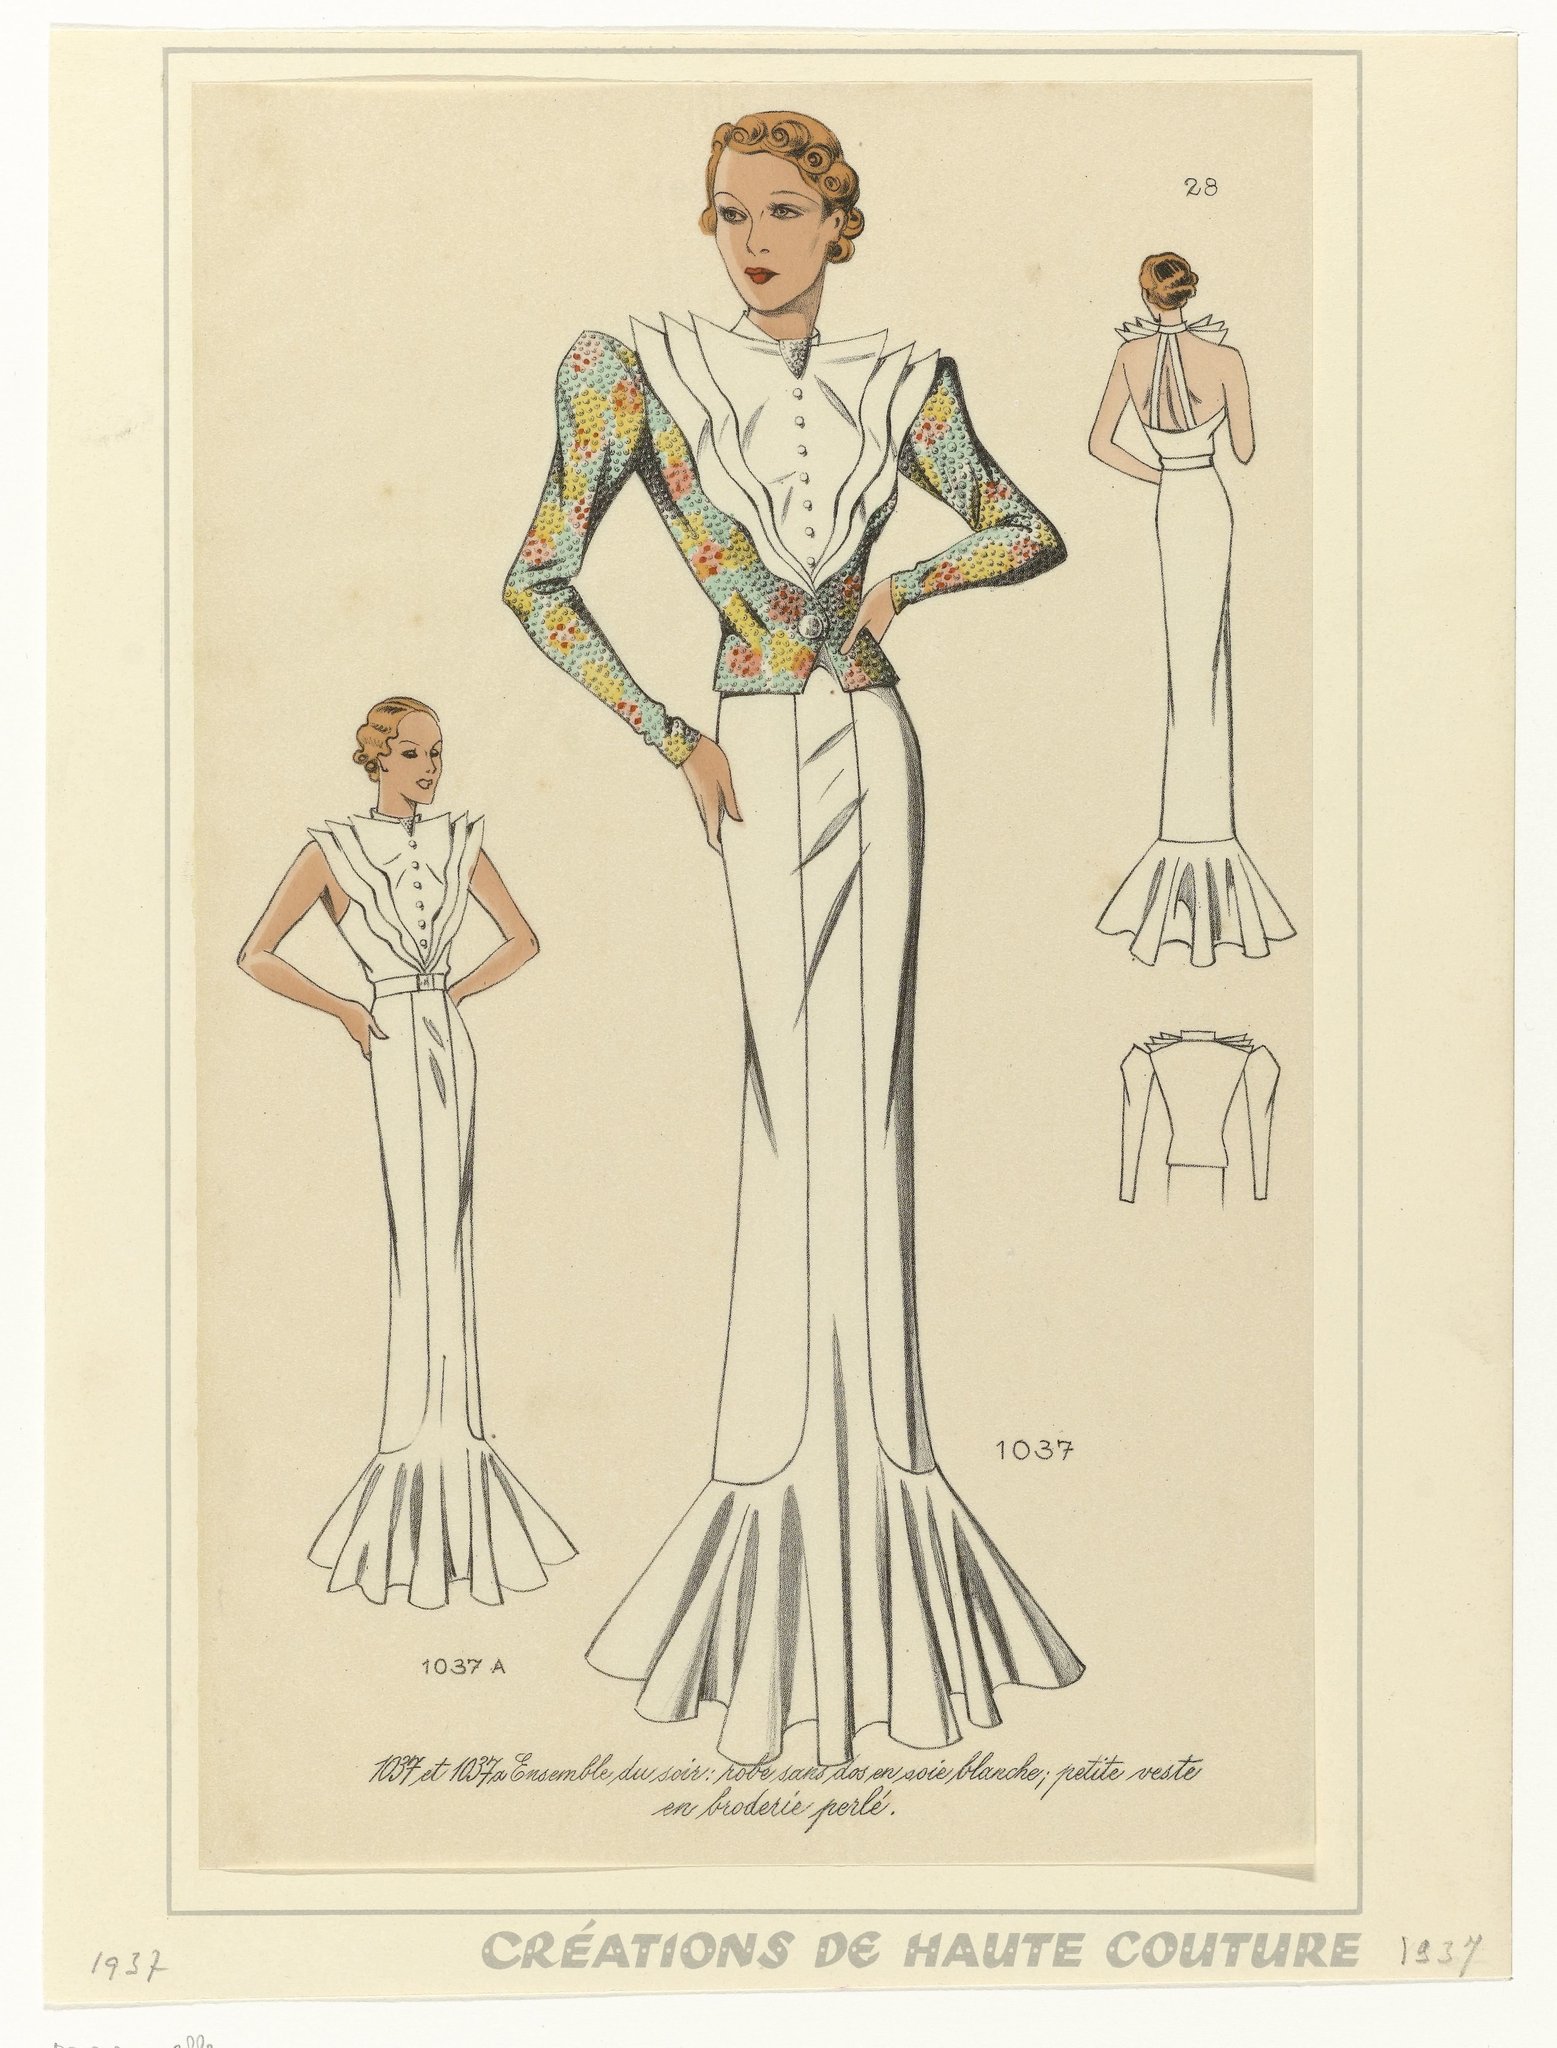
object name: fashion print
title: Créations de Haute Couture, No. 28, No. 1037, 1037A : Ensemble du soir (...)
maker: Anonymous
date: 1937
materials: paper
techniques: hand coloring, lithograph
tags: dress, gown: evening dress (+ women's clothes), clothing for the upper part of the body (jacket) (+ women's clothes), fashion plates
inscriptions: title: ‘Créations de Haute Couture’, caption: ‘1037 et 1037a Ensemble du soir: robe sans dos en soie blanche; petite veste en broderie perlé.’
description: Ensemble voor de avond. Japon met open rug in witte zijde waarover een kort jasje.